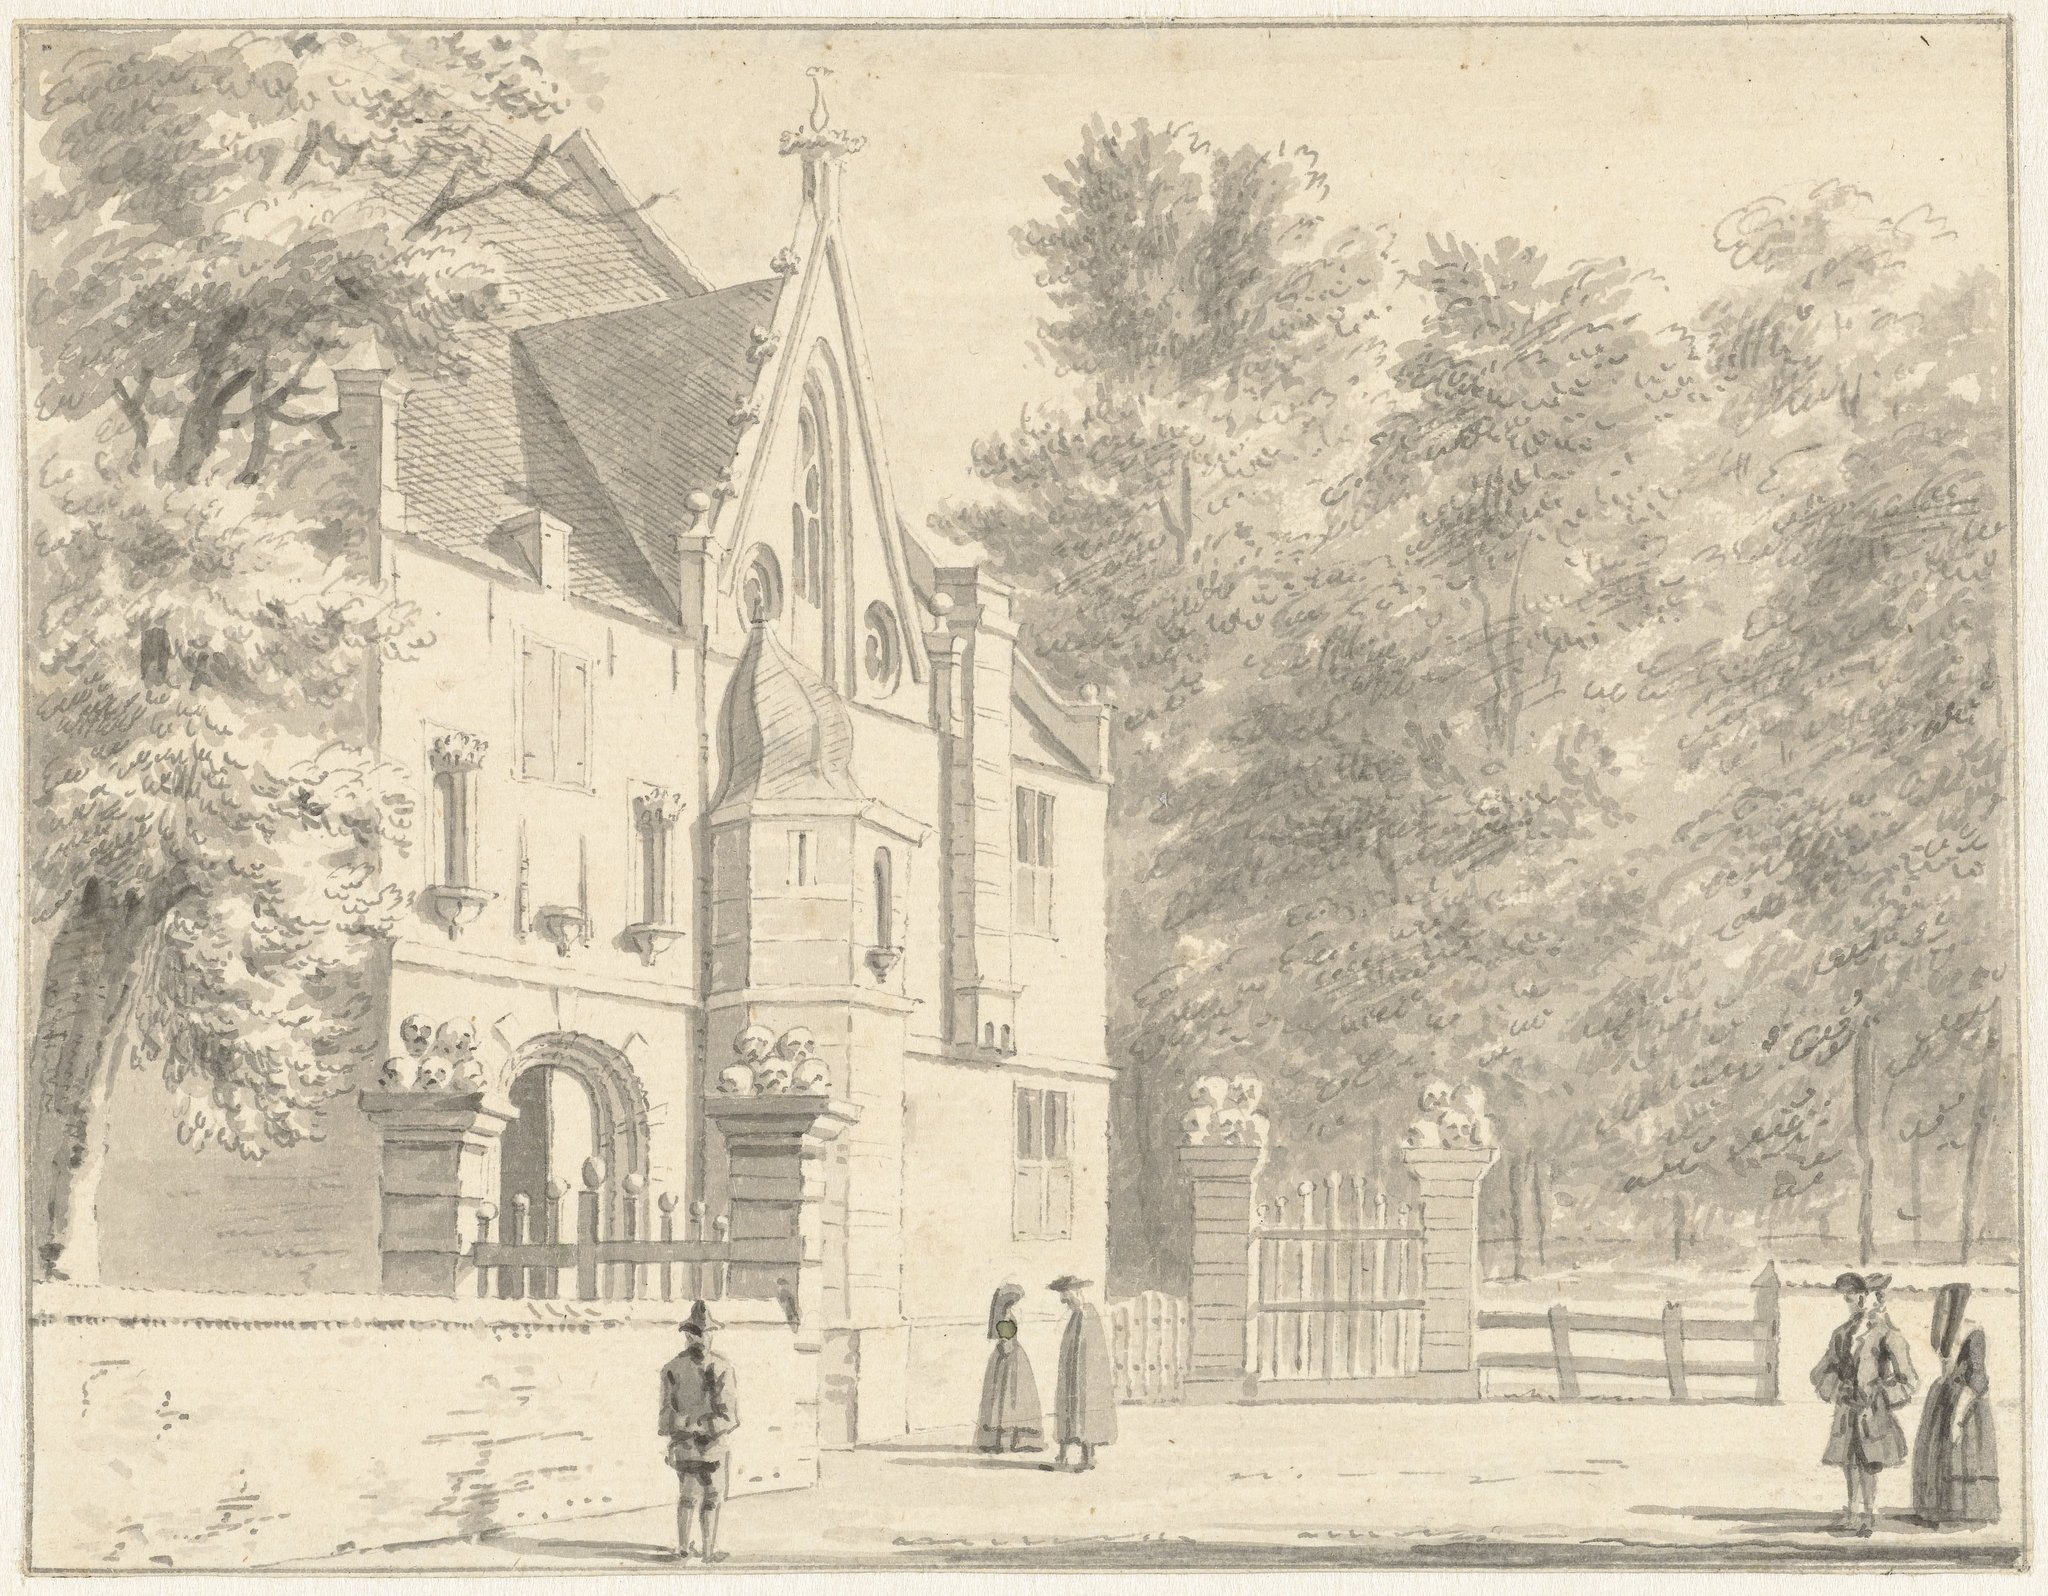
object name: drawing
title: Achterste deel van de Grote kerk te Edam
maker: cornelis pronk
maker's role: draughtsman, painter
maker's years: 1691-1759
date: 1727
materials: ink, paper, pencil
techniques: brush, pen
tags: church (exterior)